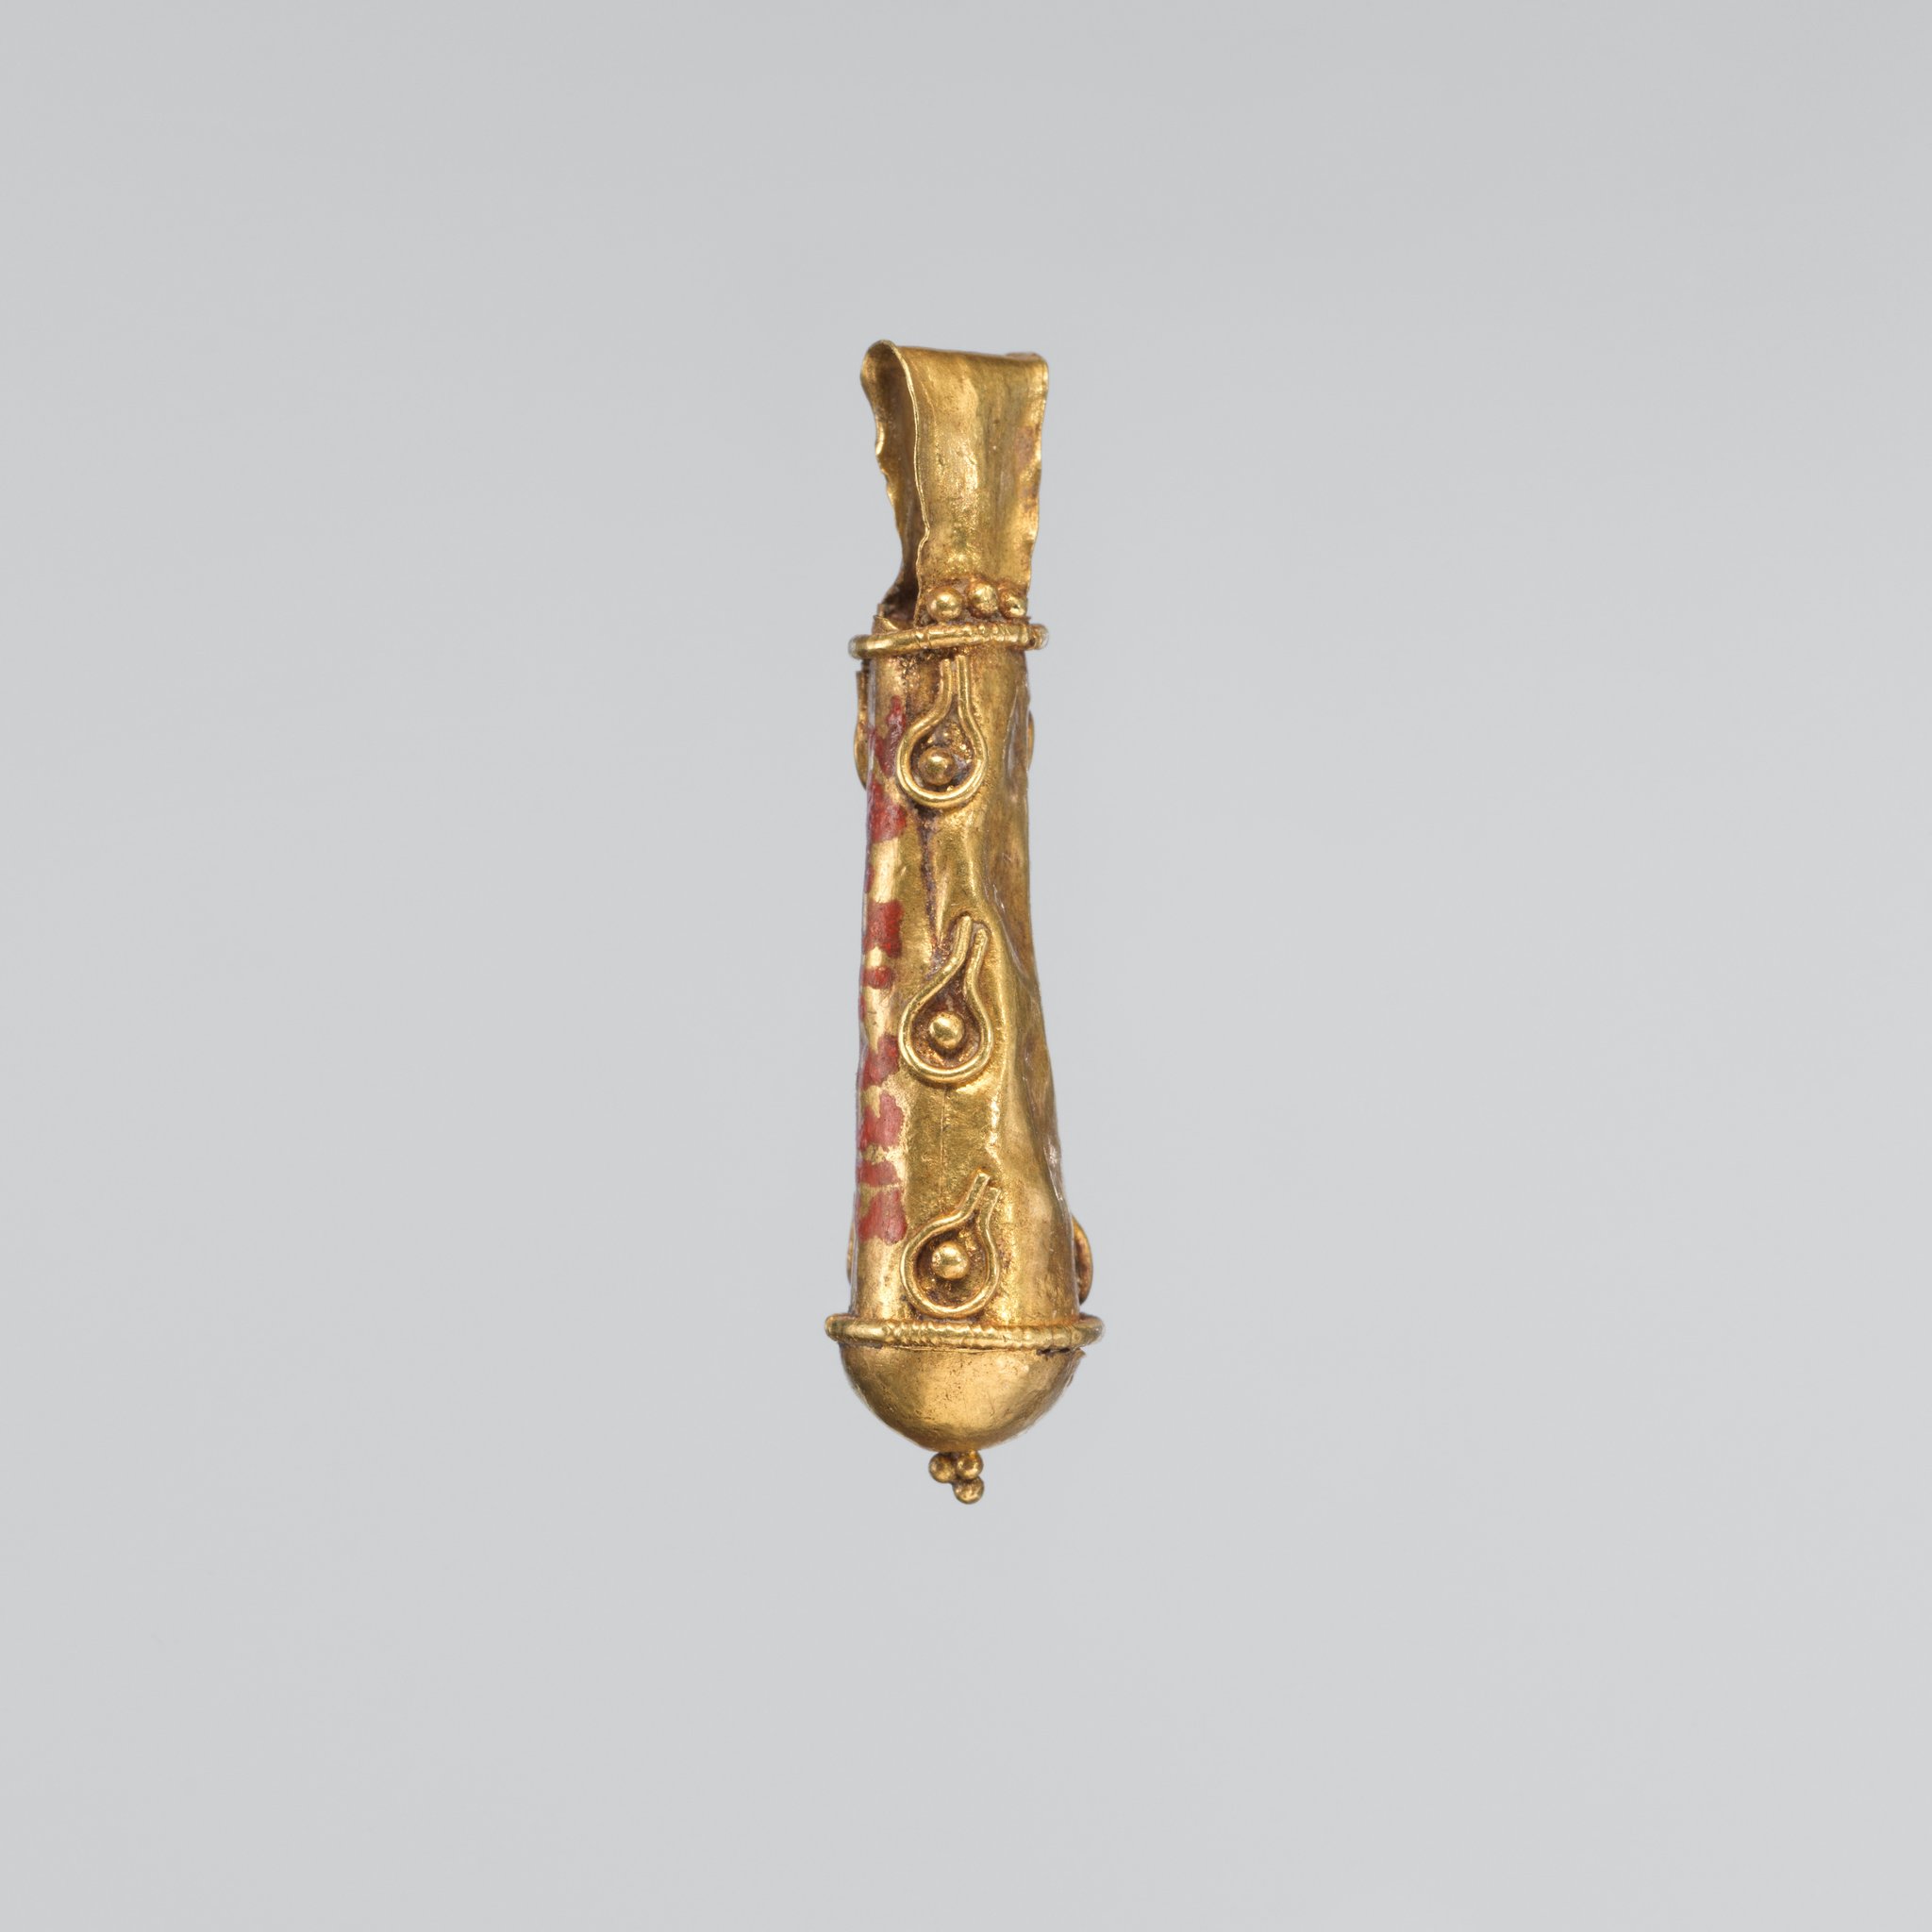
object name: pendant in the form of herakles' club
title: Gold pendant in the form of Herakle's club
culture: cypriot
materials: gold